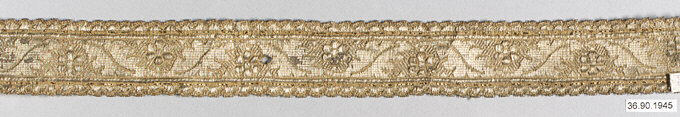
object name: galloon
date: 1701-1800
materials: silk